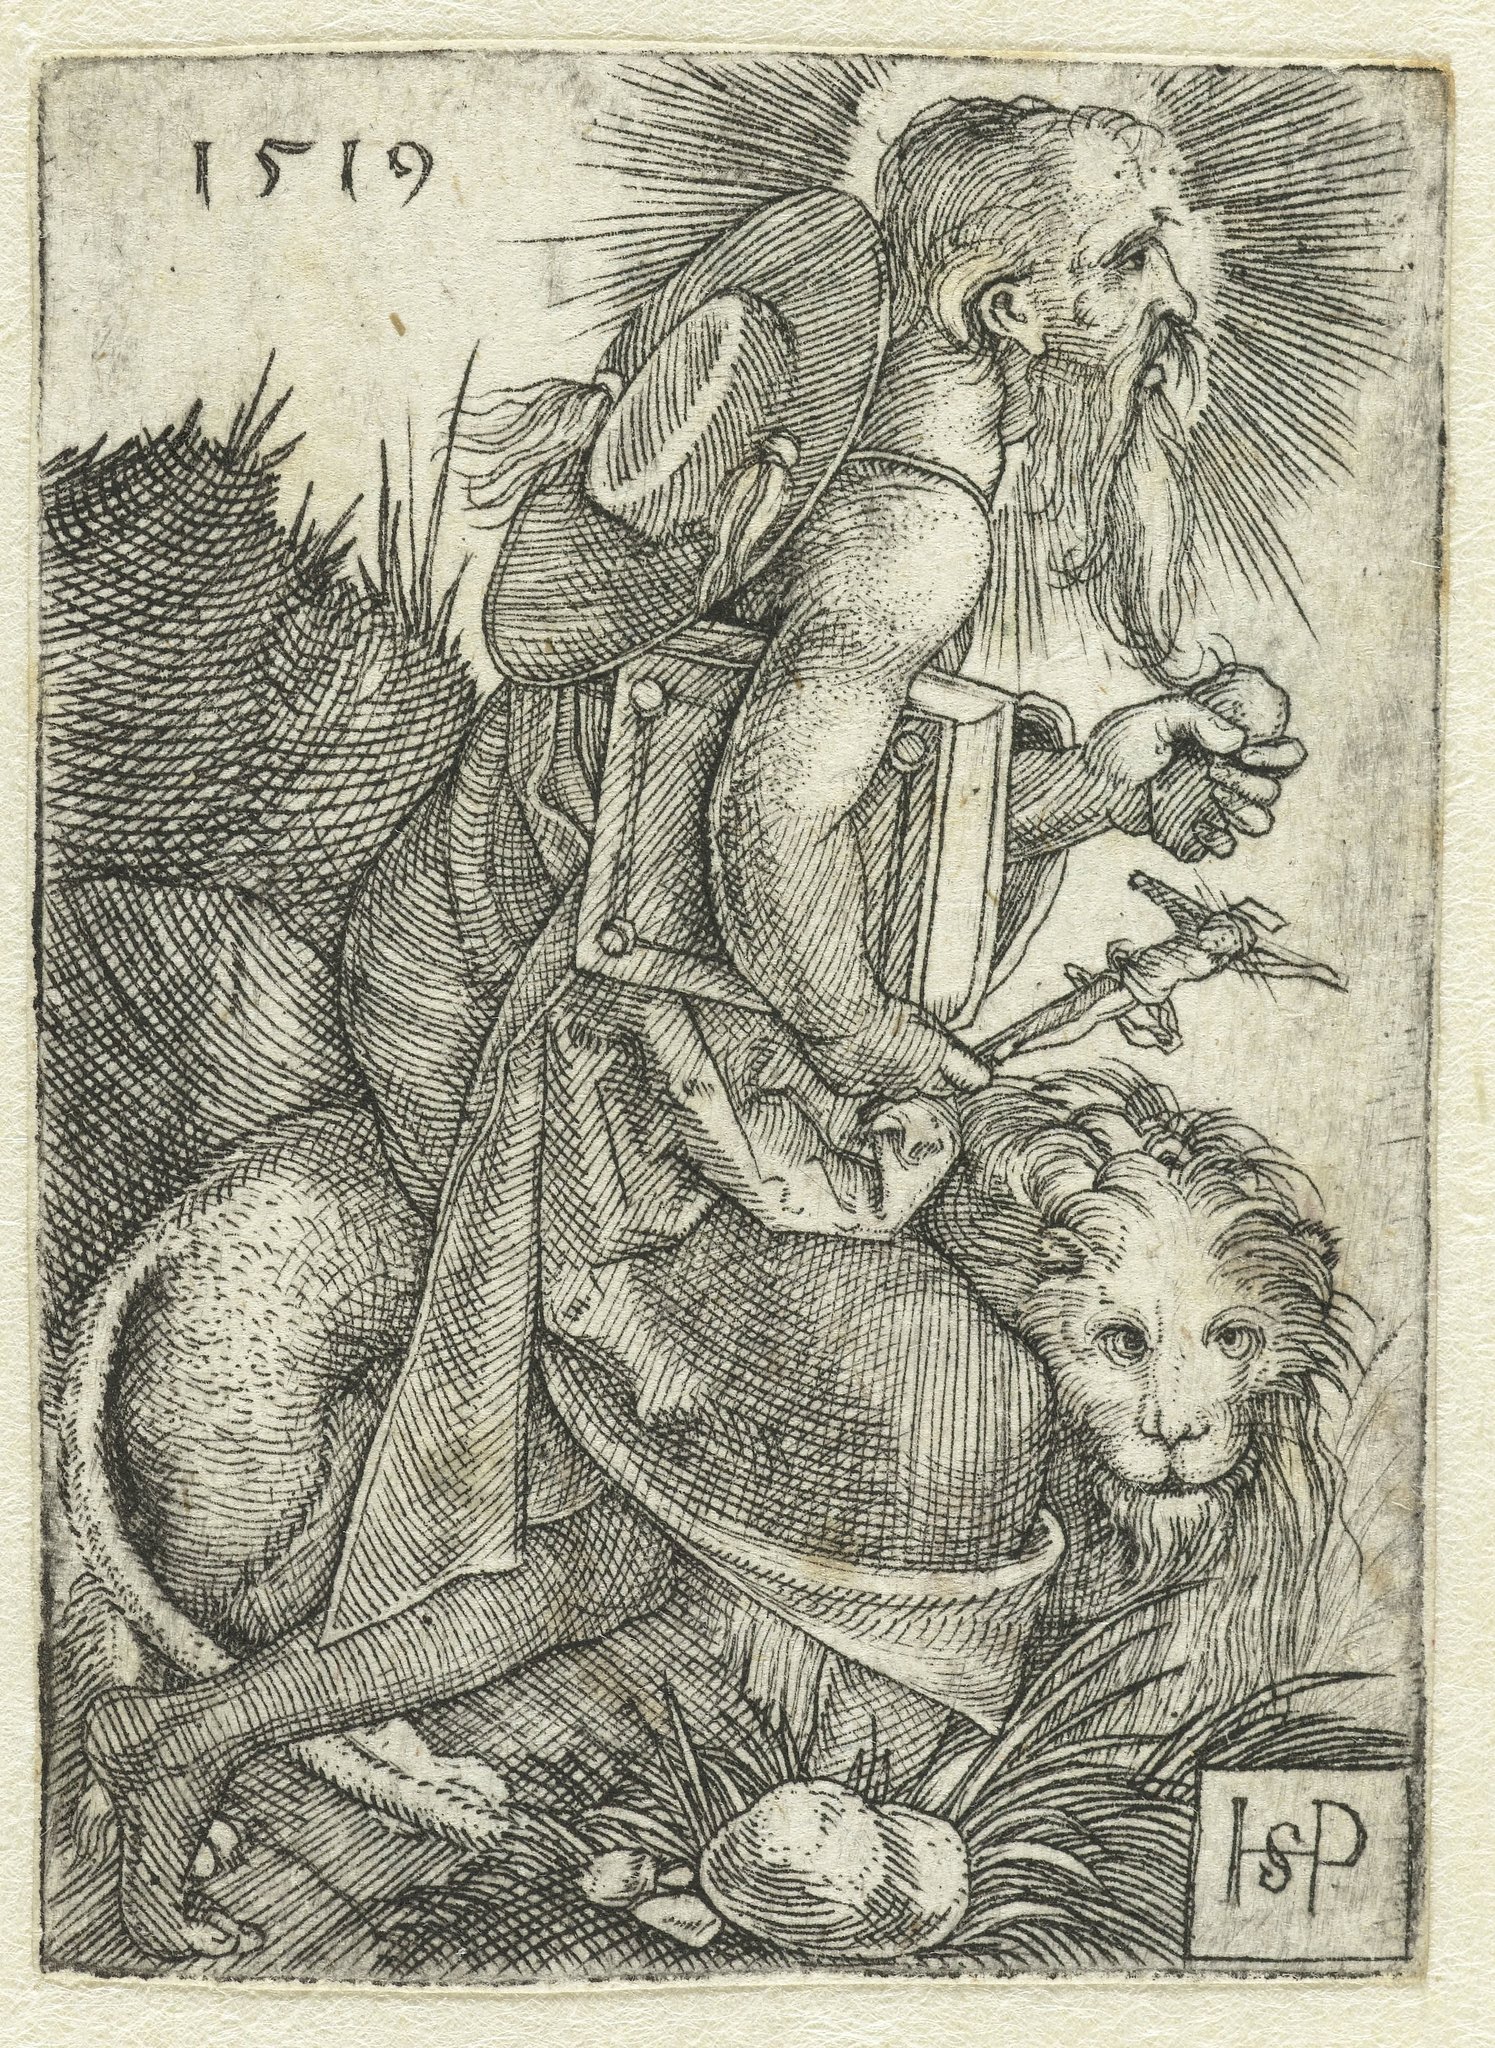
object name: print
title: Heilige Hieronymus lopend in woestijn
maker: hans sebald beham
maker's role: designer, draughtsman, print maker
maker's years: 1500-1550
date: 1519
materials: paper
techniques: engraving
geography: nuremberg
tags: the monk and hermit jerome (hieronymus); possible attributes: book, cardinal's hat, crucifix, hour-glass, lion, skull, stone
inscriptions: collector's mark: Lugt 240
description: Heilige Hieronymus lopend in de woestijn met de attributen waarmee hij in zijn rol als boeteling werd afgebeeld, een crucifix en een steen. Op zijn rug draagt hij een kardinaalshoed en naast hem loopt een leeuw welke verwijzen naar andere gebeurtenissen in het leven van deze kerkvader.